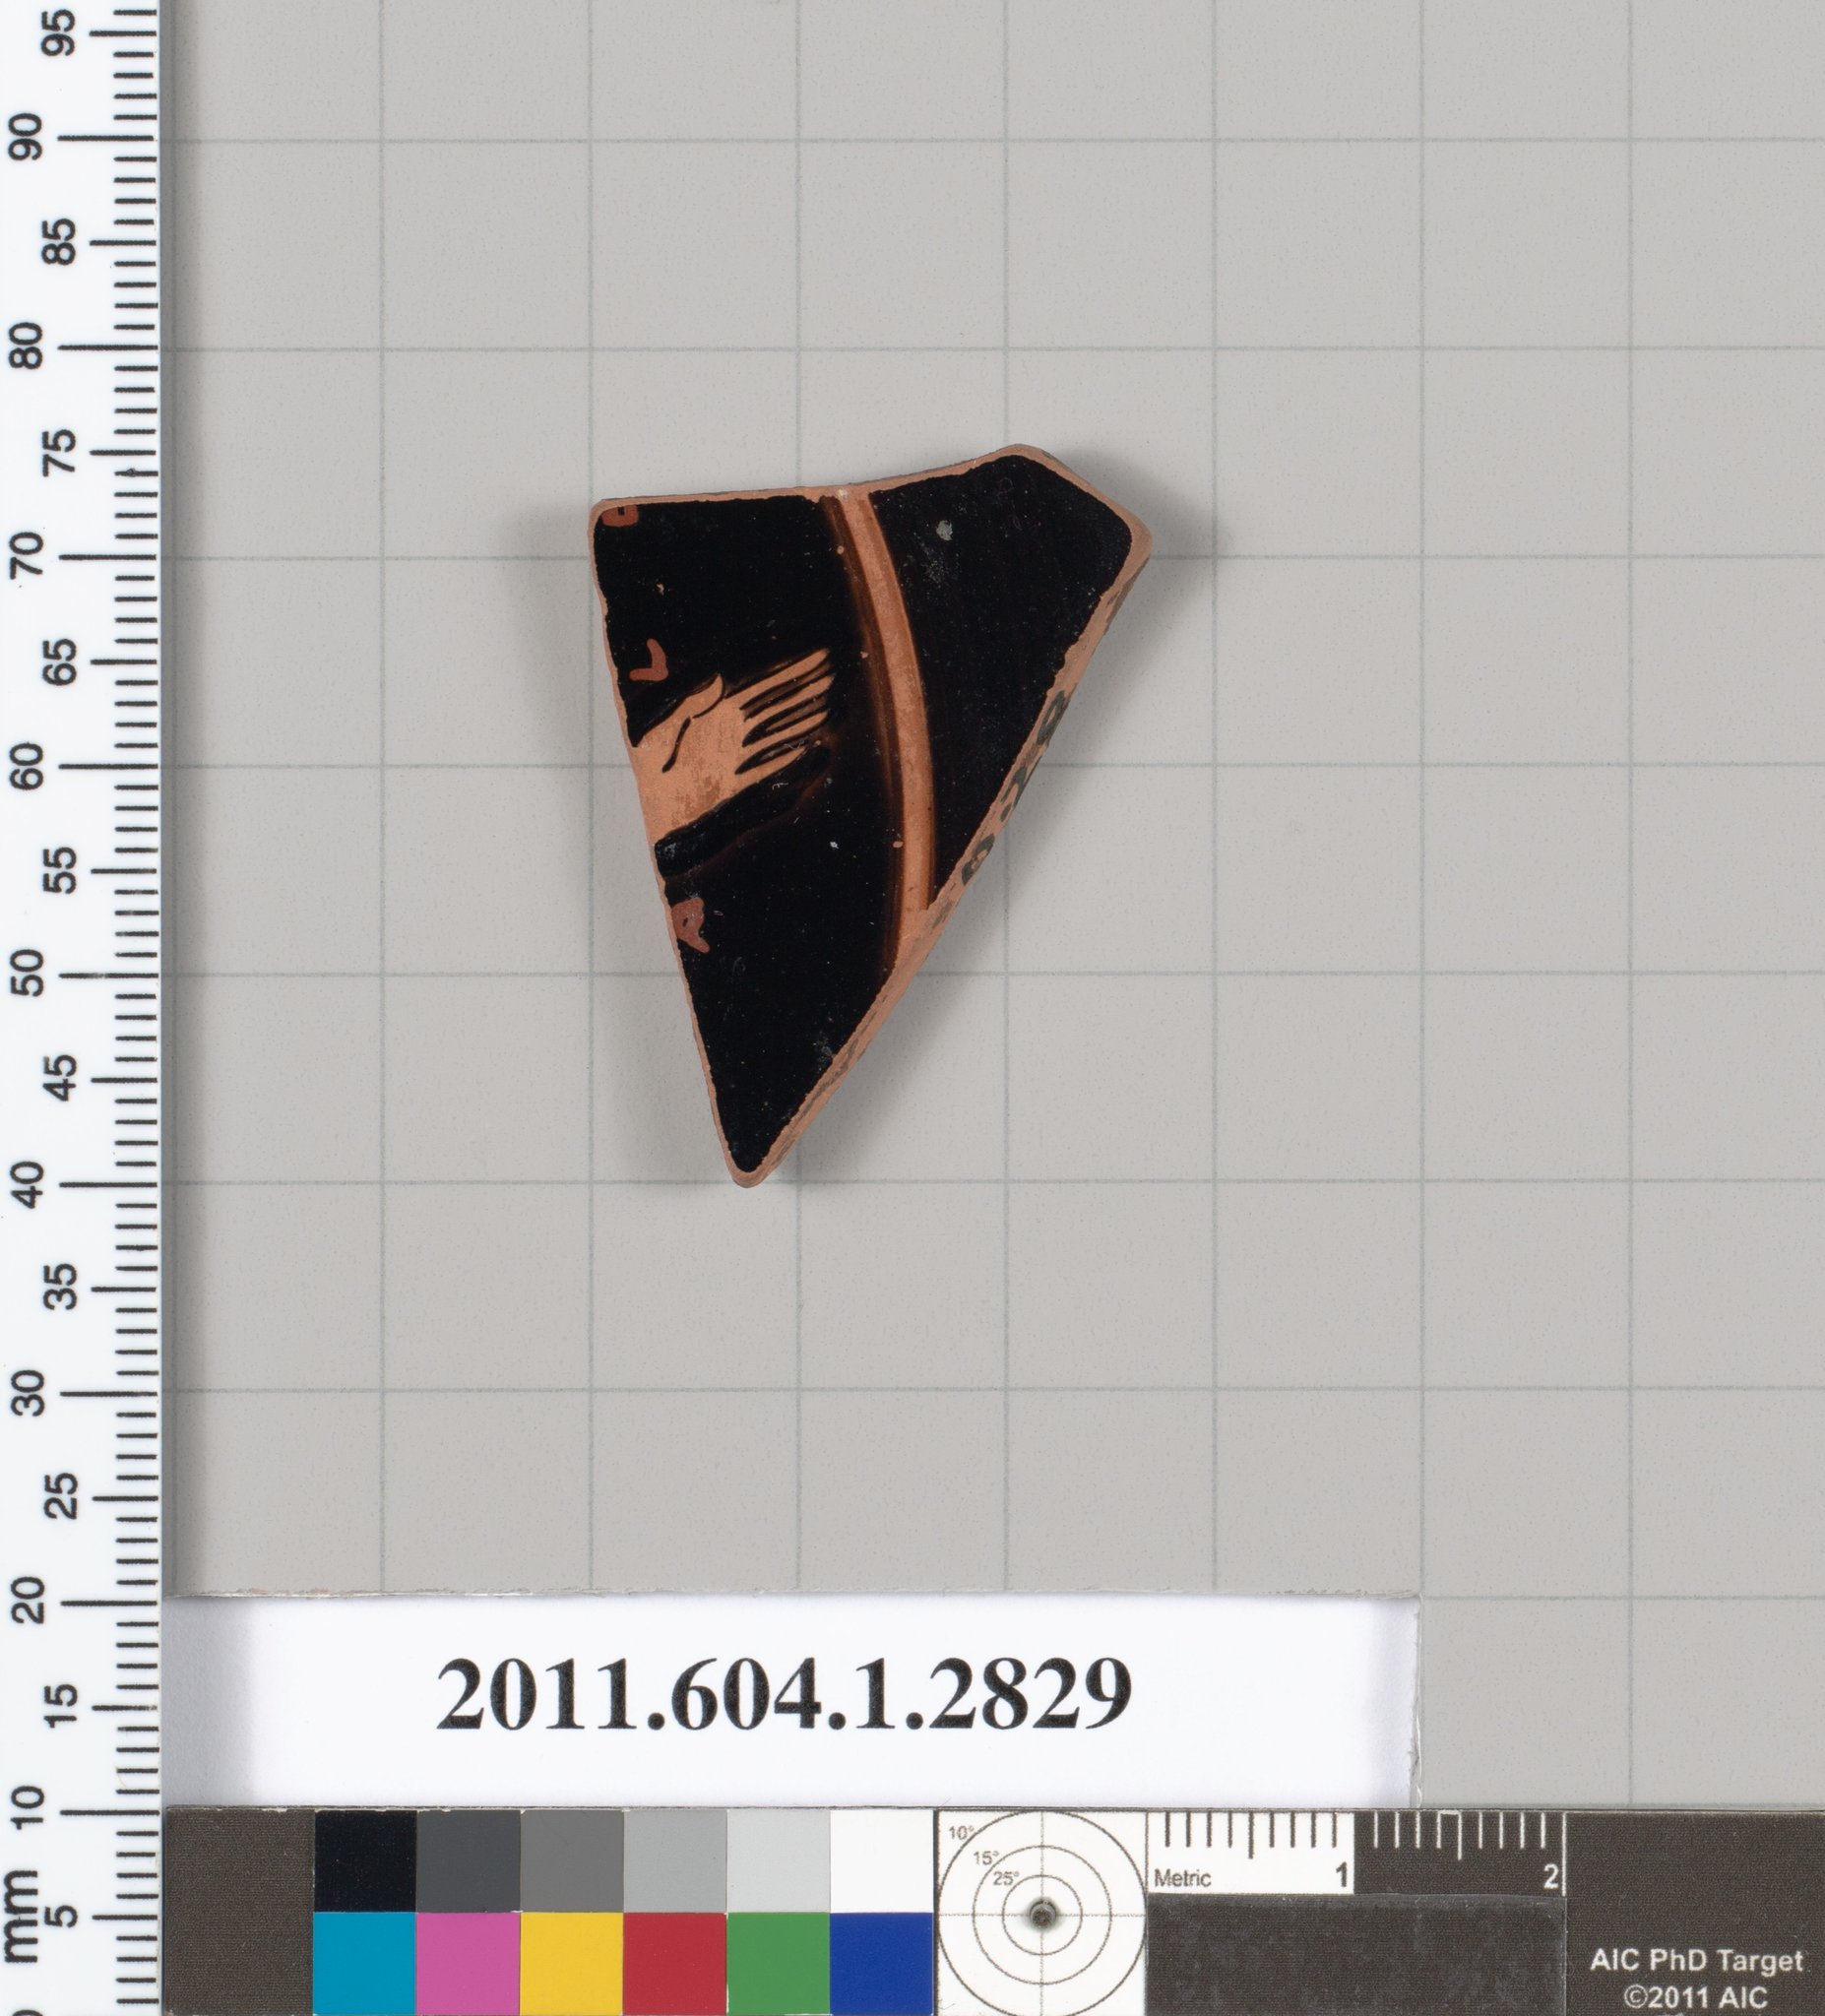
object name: kylix fragment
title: Terracotta fragment of a kylix (drinking cup)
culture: greek, attic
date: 520-500 BCE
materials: terracotta